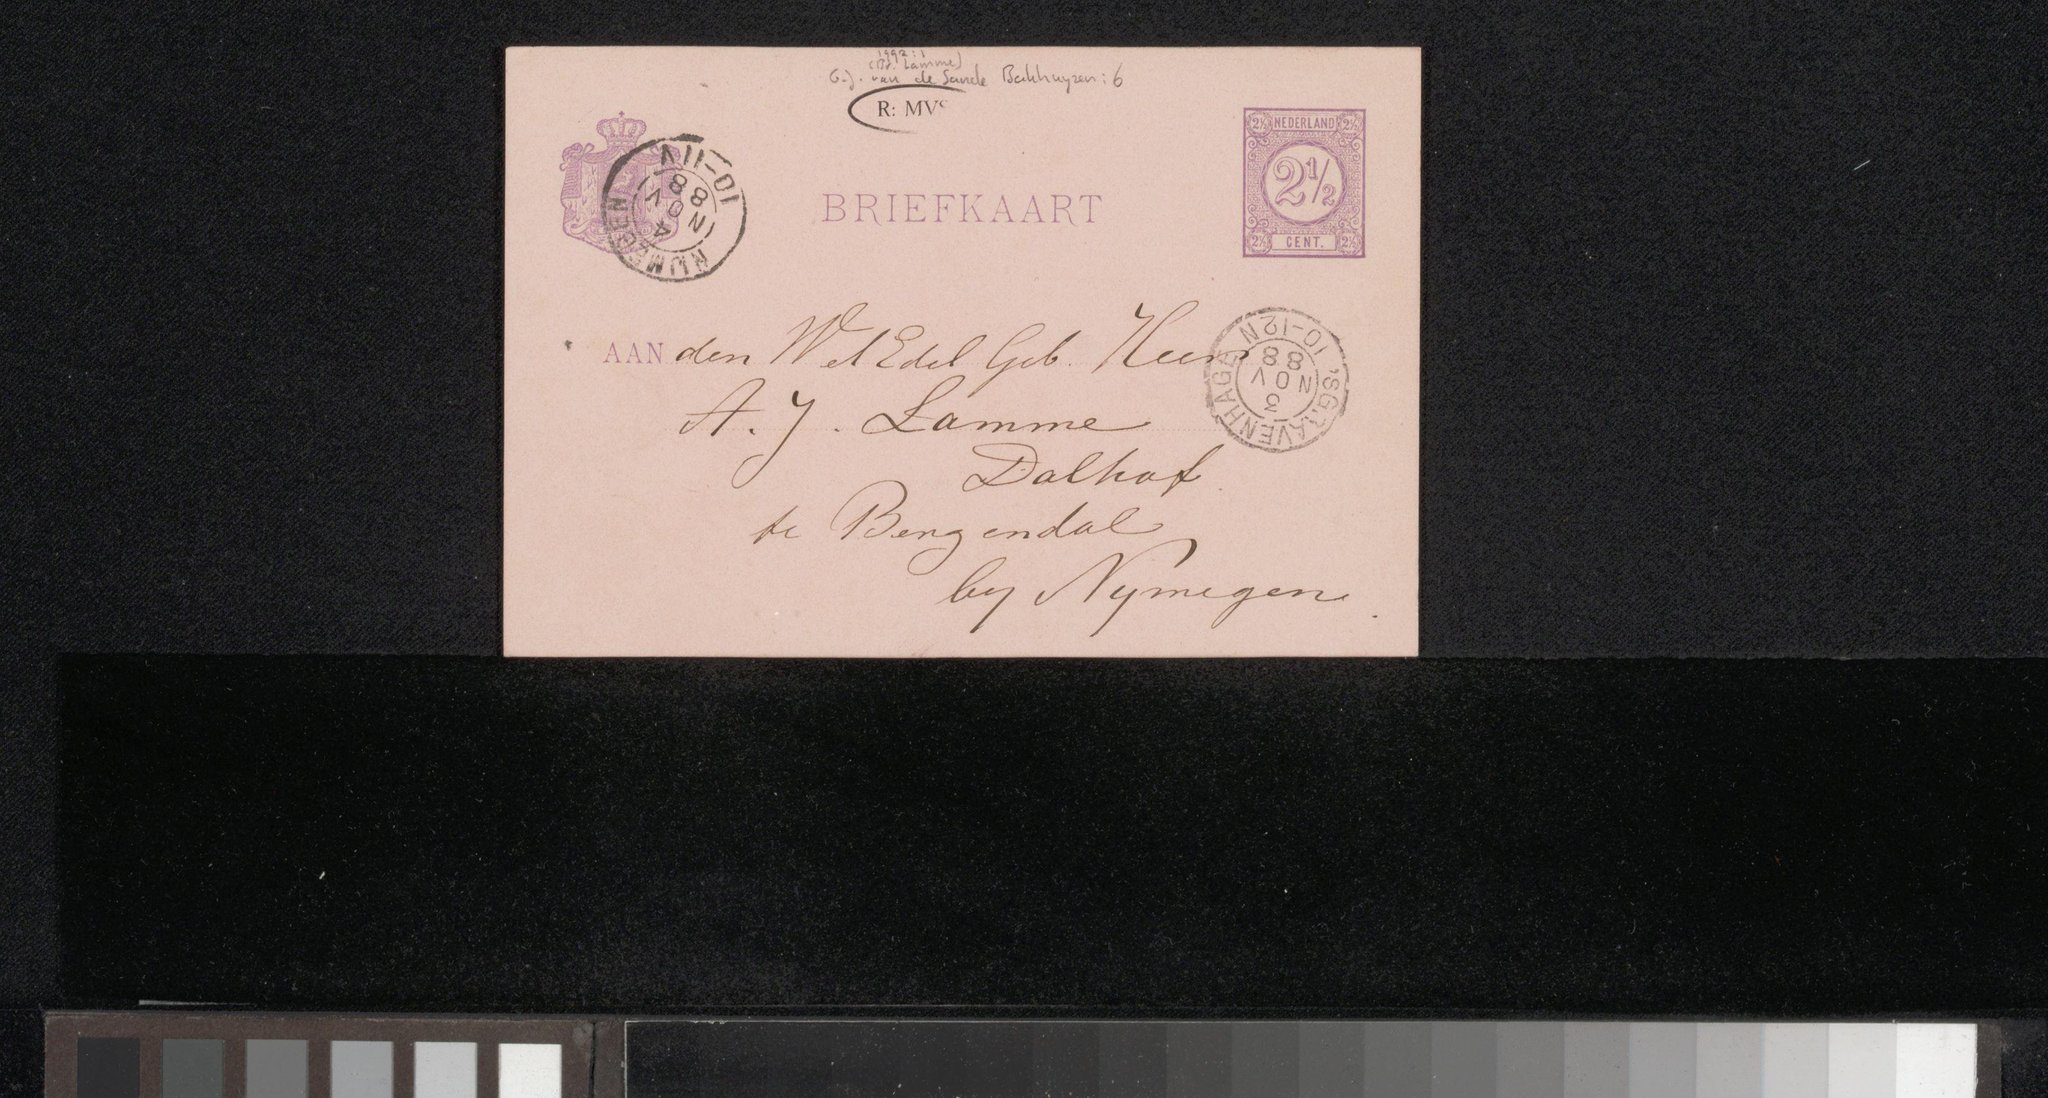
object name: postcard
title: Briefkaart aan Ary Johannes Lamme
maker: julius jacobus van de sande bakhuyzen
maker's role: draughtsman, painter, print maker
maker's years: 1835-1925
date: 1888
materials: cardboard, ink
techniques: pen, writing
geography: the hague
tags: dordrecht, print maker, draughtsman, ary johannes lamme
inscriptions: collector's mark: Lugt 2228